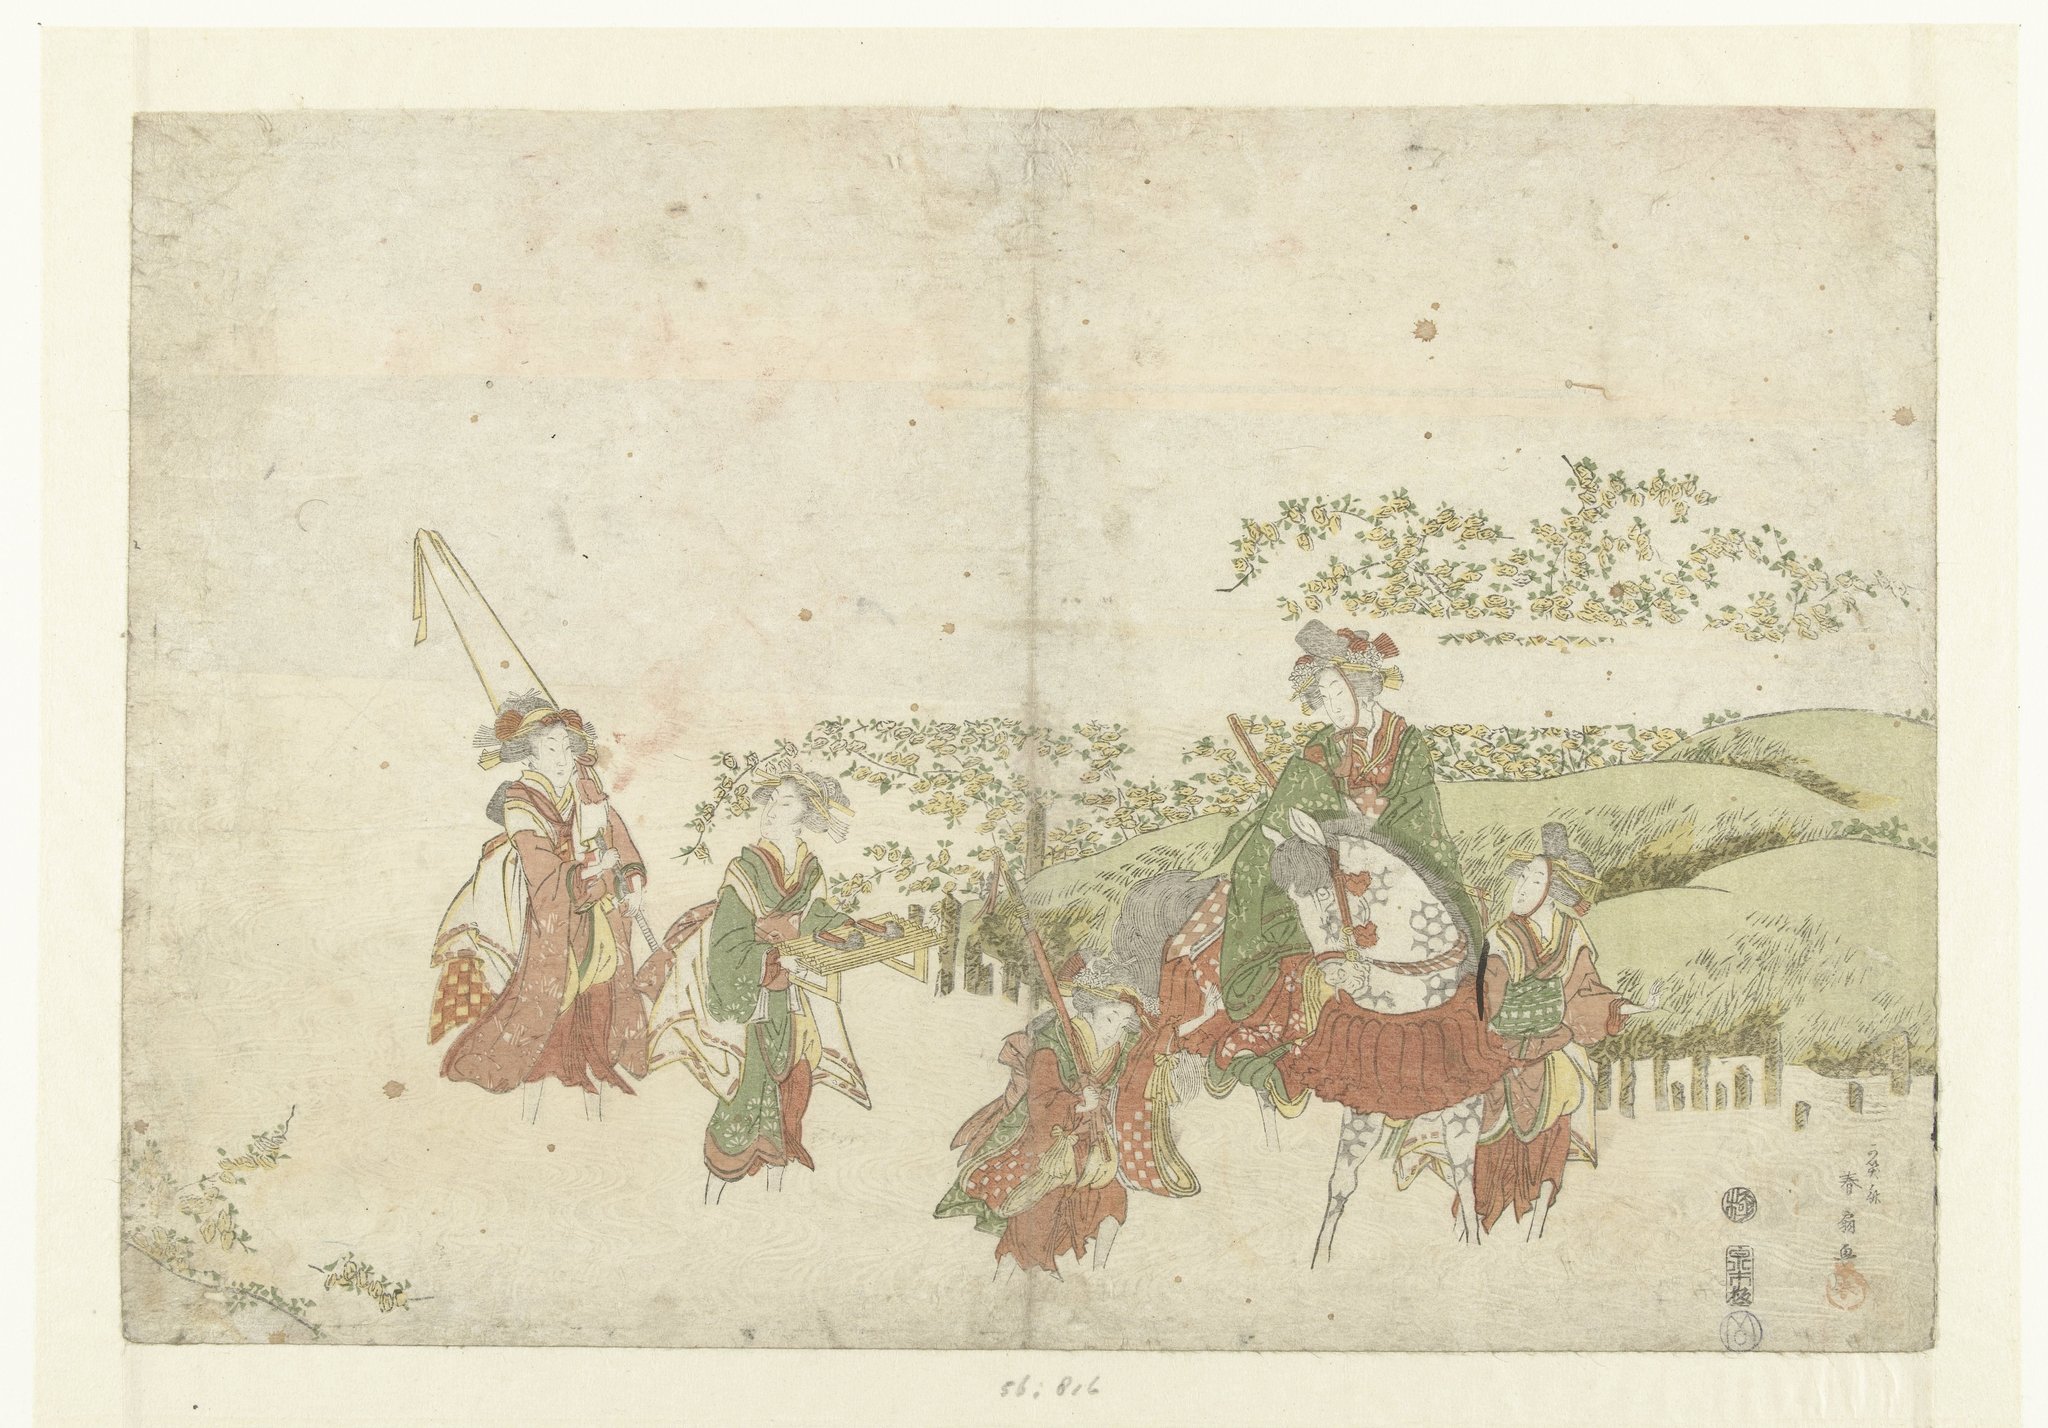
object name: print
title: De Ide Tama rivier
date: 1800-1810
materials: paper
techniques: blind stamped, woodcut, nishiki e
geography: japan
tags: riding a horse, ass, or mule; rider, horseman, landscapes (+ landscape with figures, staffage), house personnel, servants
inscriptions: collector's mark: Lugt 600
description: Vrouw te paard, begeleid door vier dienstmeisjes lopend door ondiepe rivier waarvan de oevers begroeid met struikgewas met gele bloemen (yamabuki).